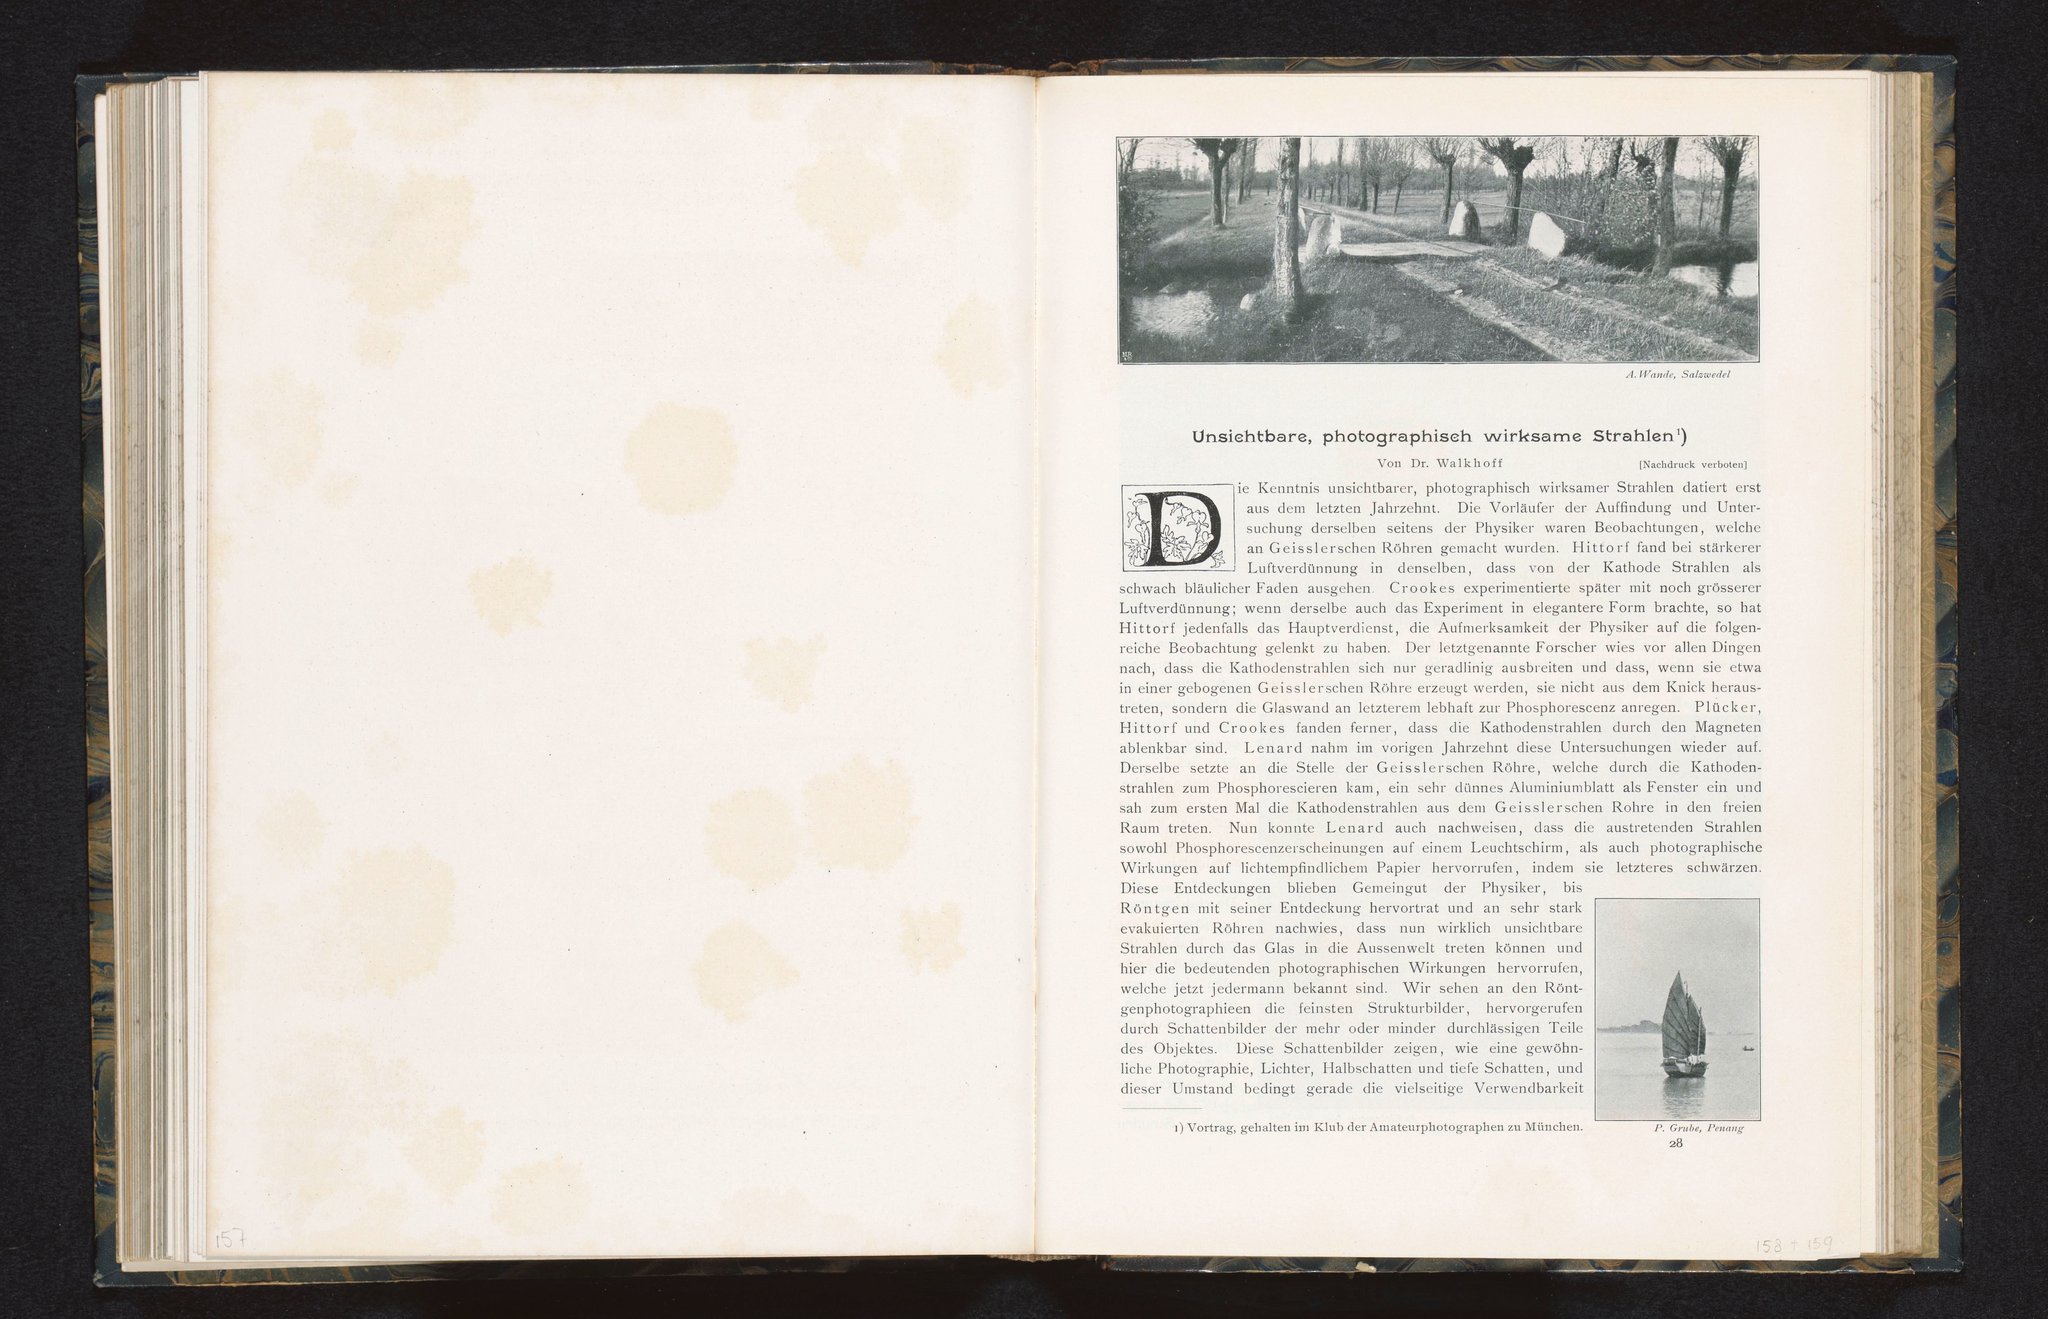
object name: page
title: Gezicht op een zeilboot te water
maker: p. grube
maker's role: fotograaf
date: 1895-1900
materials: paper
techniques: autotype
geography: berlin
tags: sailing-ship, sailing-boat, landscapes with waters, waterscapes, seascapes (in the temperate zone)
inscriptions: monogram: ‘MR/&Co’